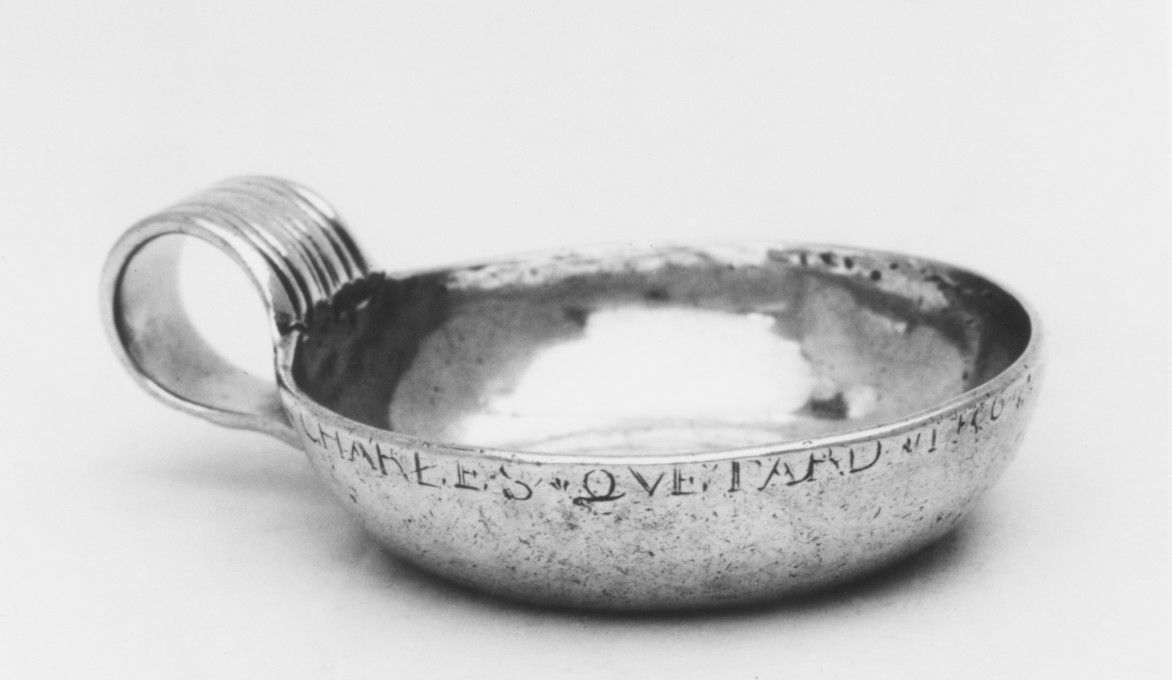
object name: wine taster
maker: antoine-françois hanappier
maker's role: maker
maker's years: 1713-1786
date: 1734-1766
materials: silver